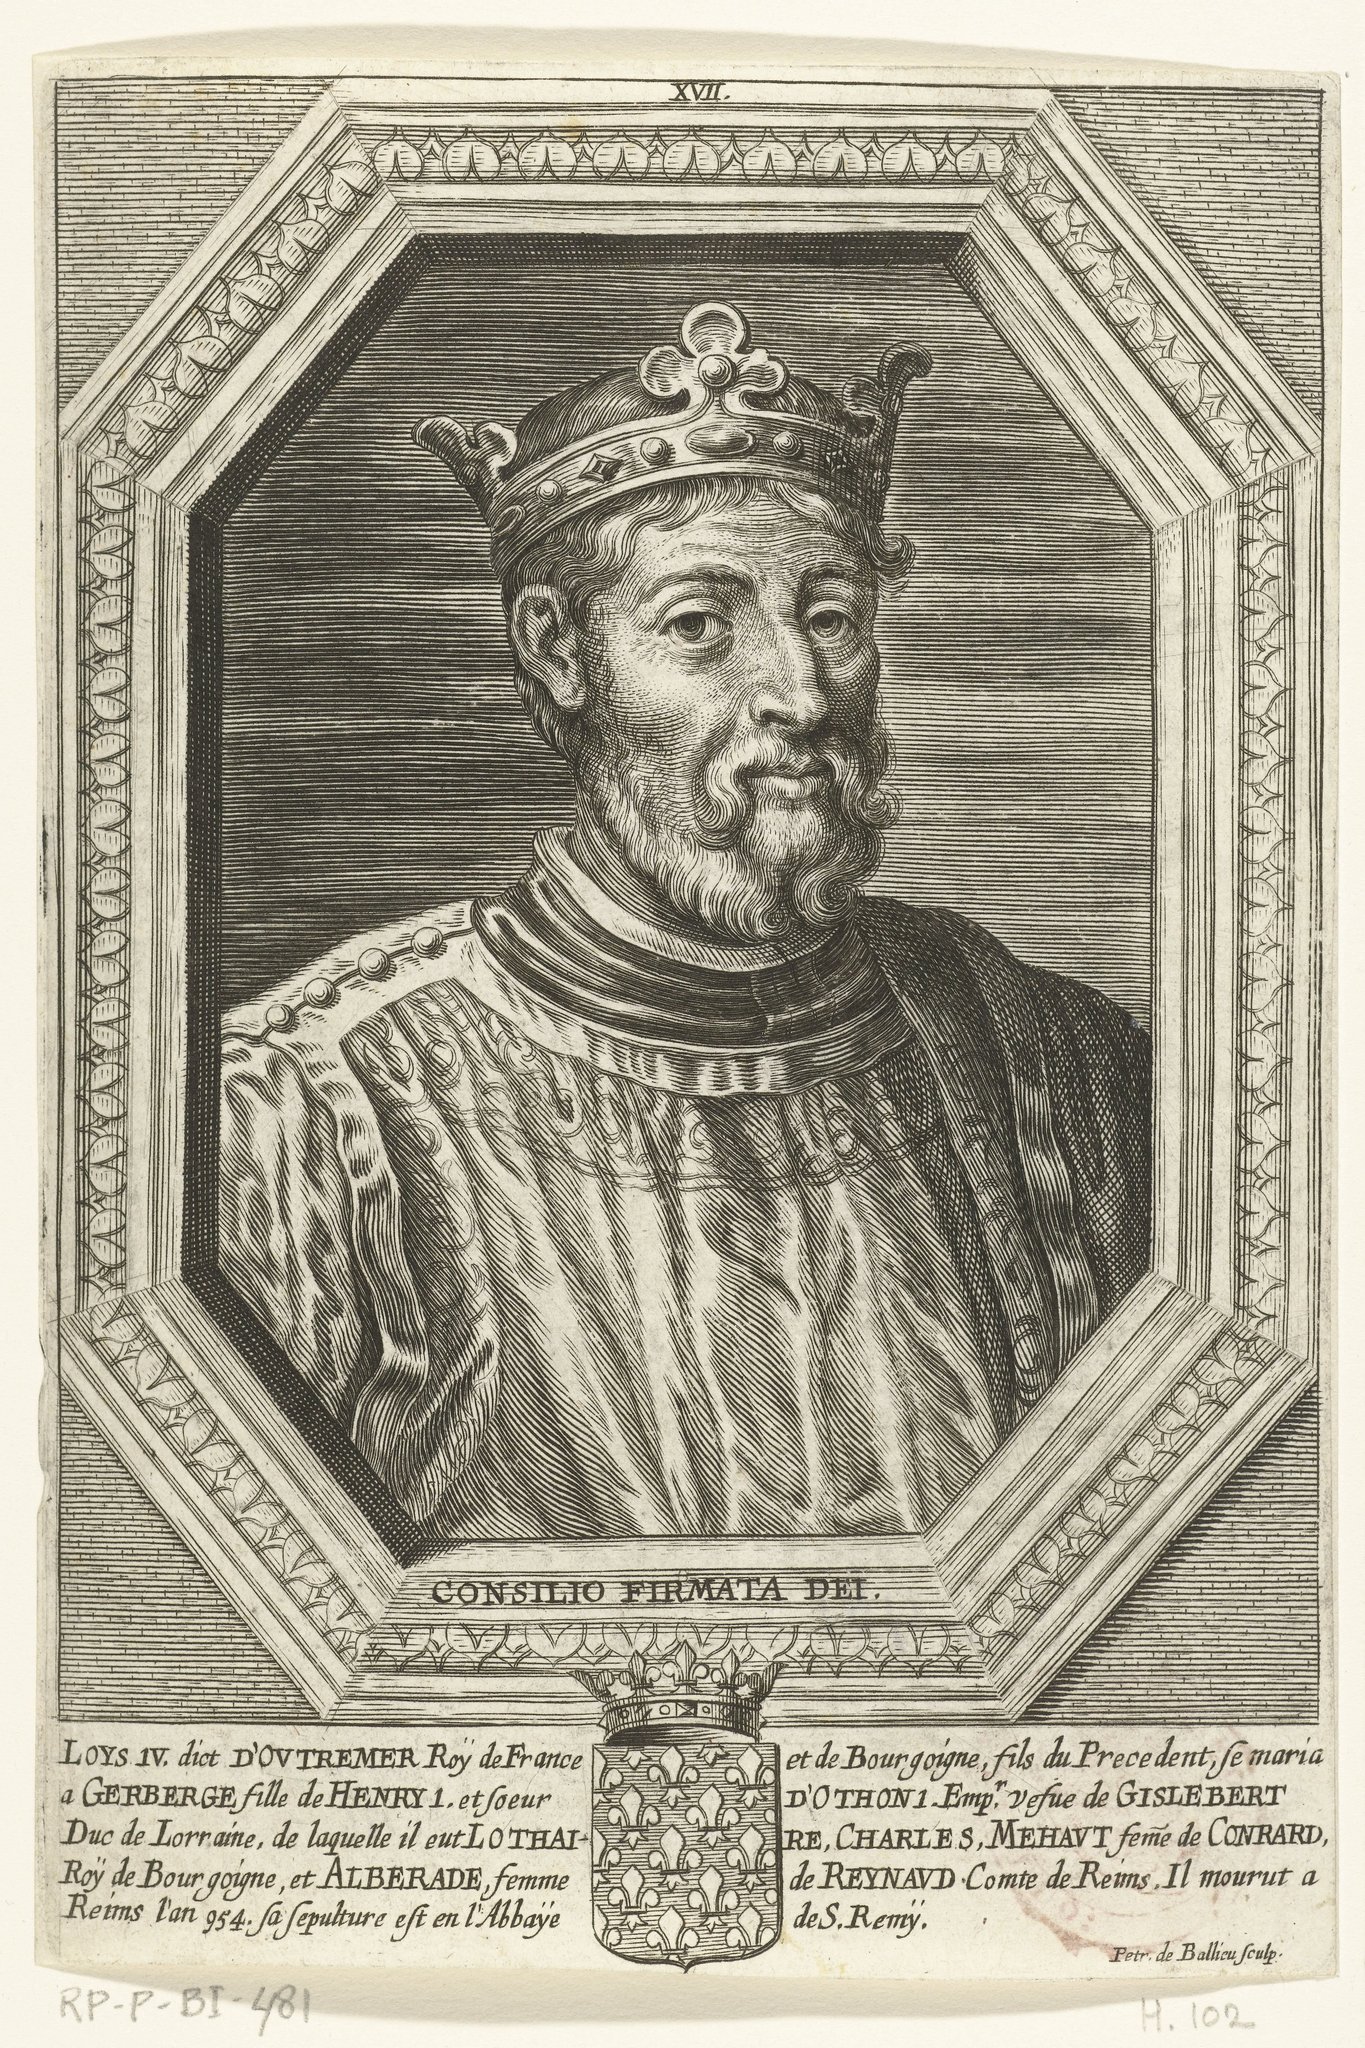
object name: print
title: Loys IV dict (...) l'Abbye de S. Remy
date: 1623-1660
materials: paper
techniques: engraving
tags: london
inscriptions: collector's mark: Lugt 240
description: Prent gebruikt voor: Les Effigies des Souverains princes et Ducs de Brabant. Joannes Meyssens (uitgever), Antwerpen 1661. De publicatie bevat vierenvijftig portretten waarvan zes door Pieter de Bailliu.